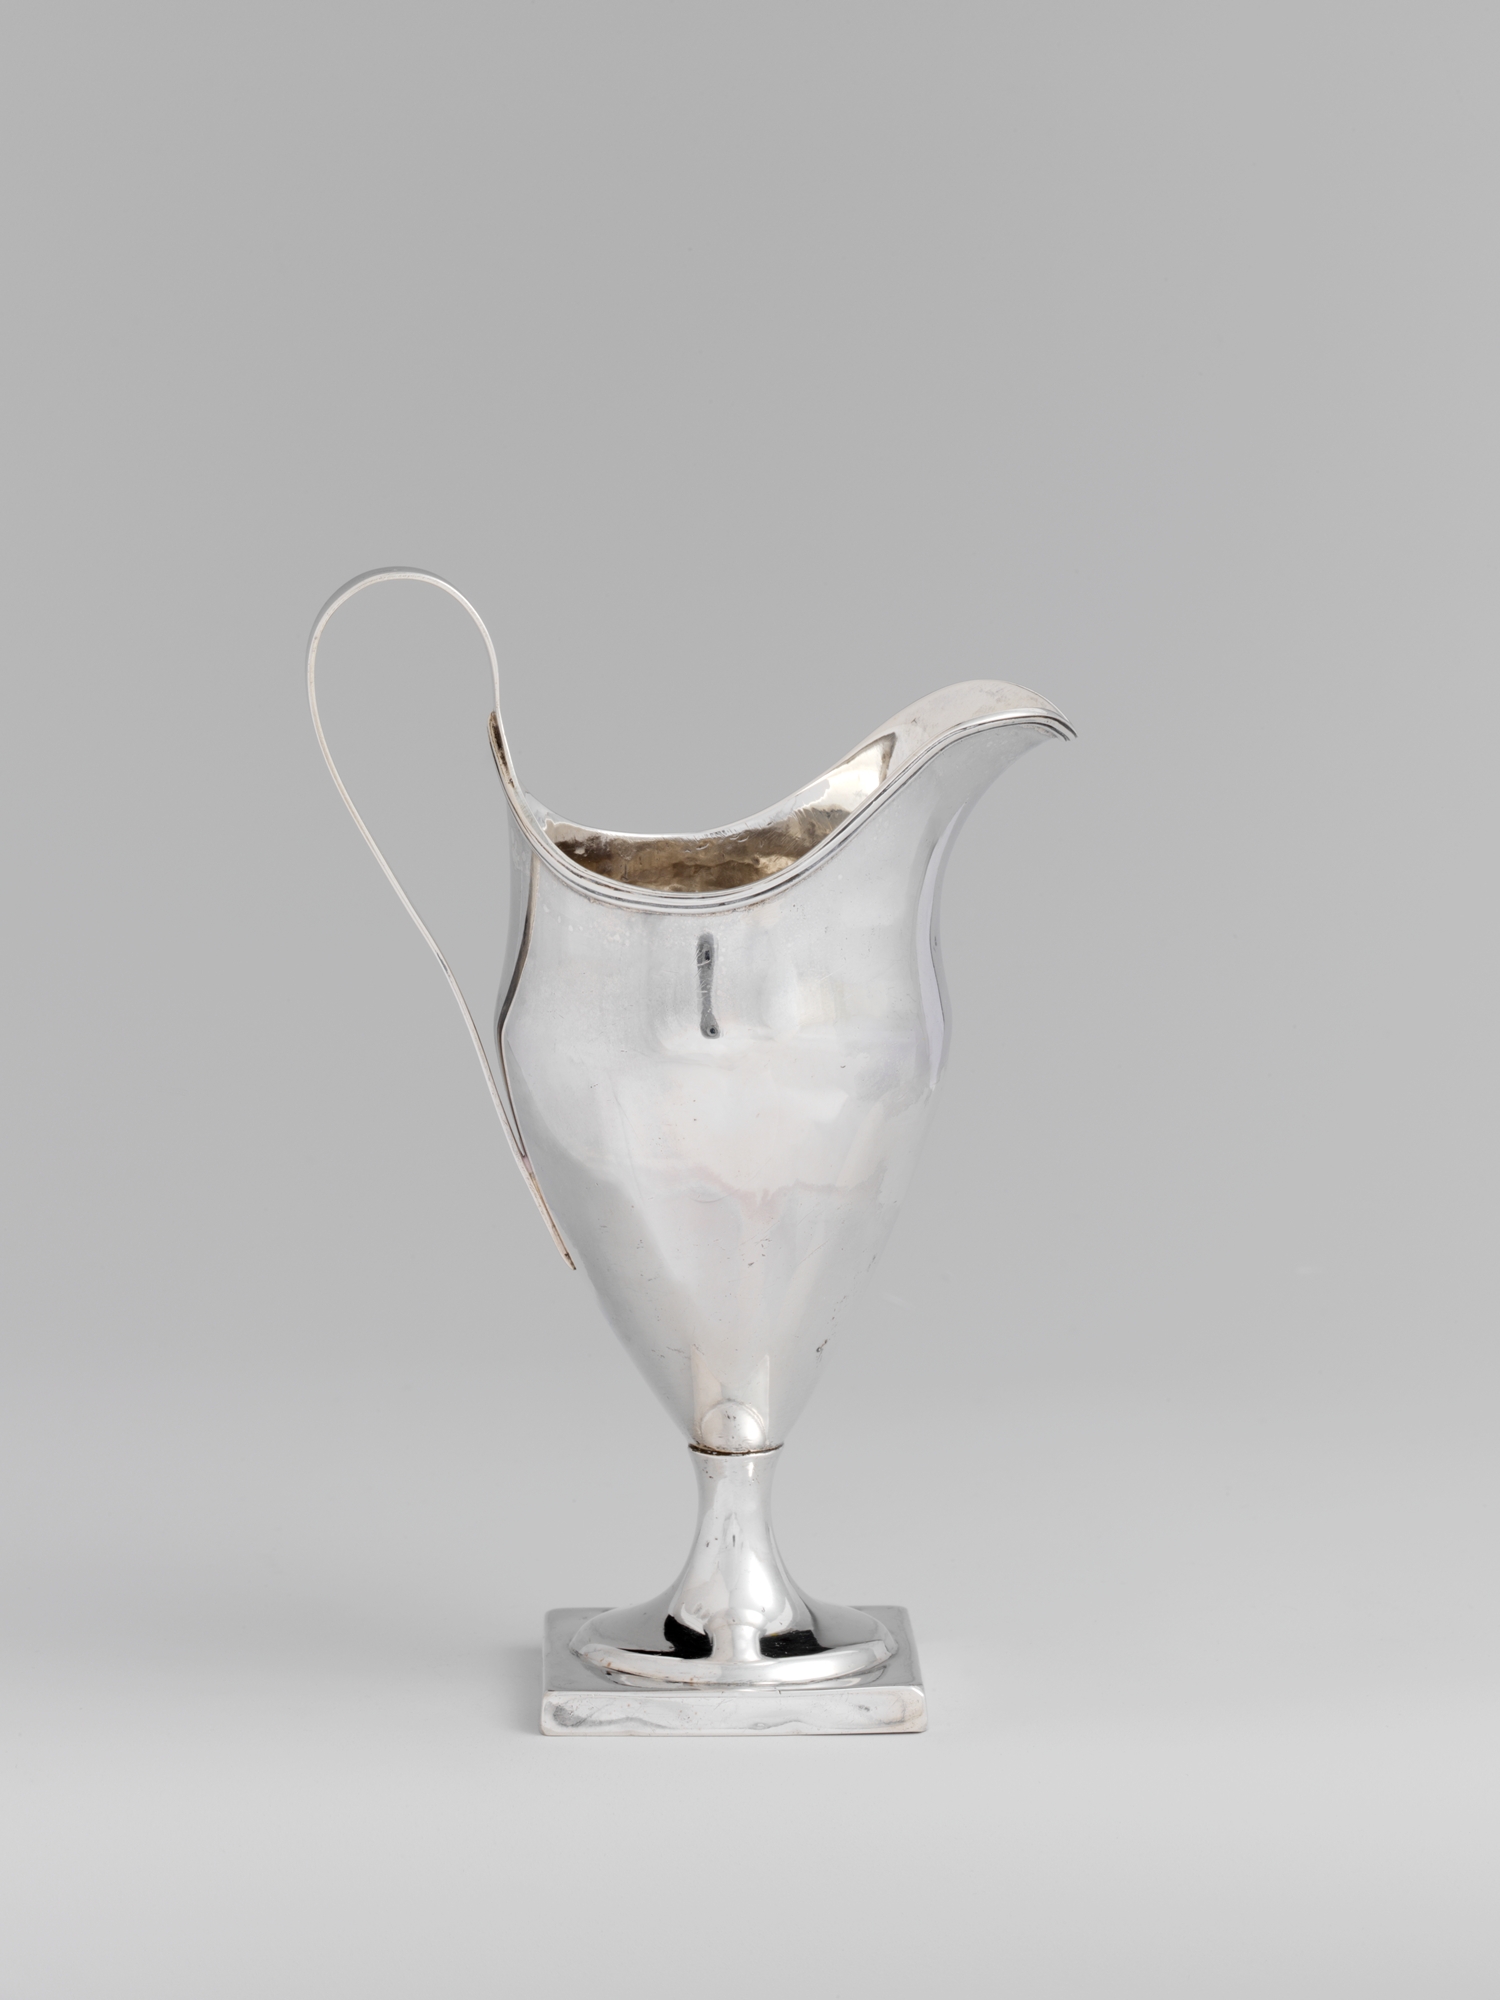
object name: cream pot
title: Creamer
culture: american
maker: hugh wishart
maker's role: maker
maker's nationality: american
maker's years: 1793-1824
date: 1800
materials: silver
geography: united states